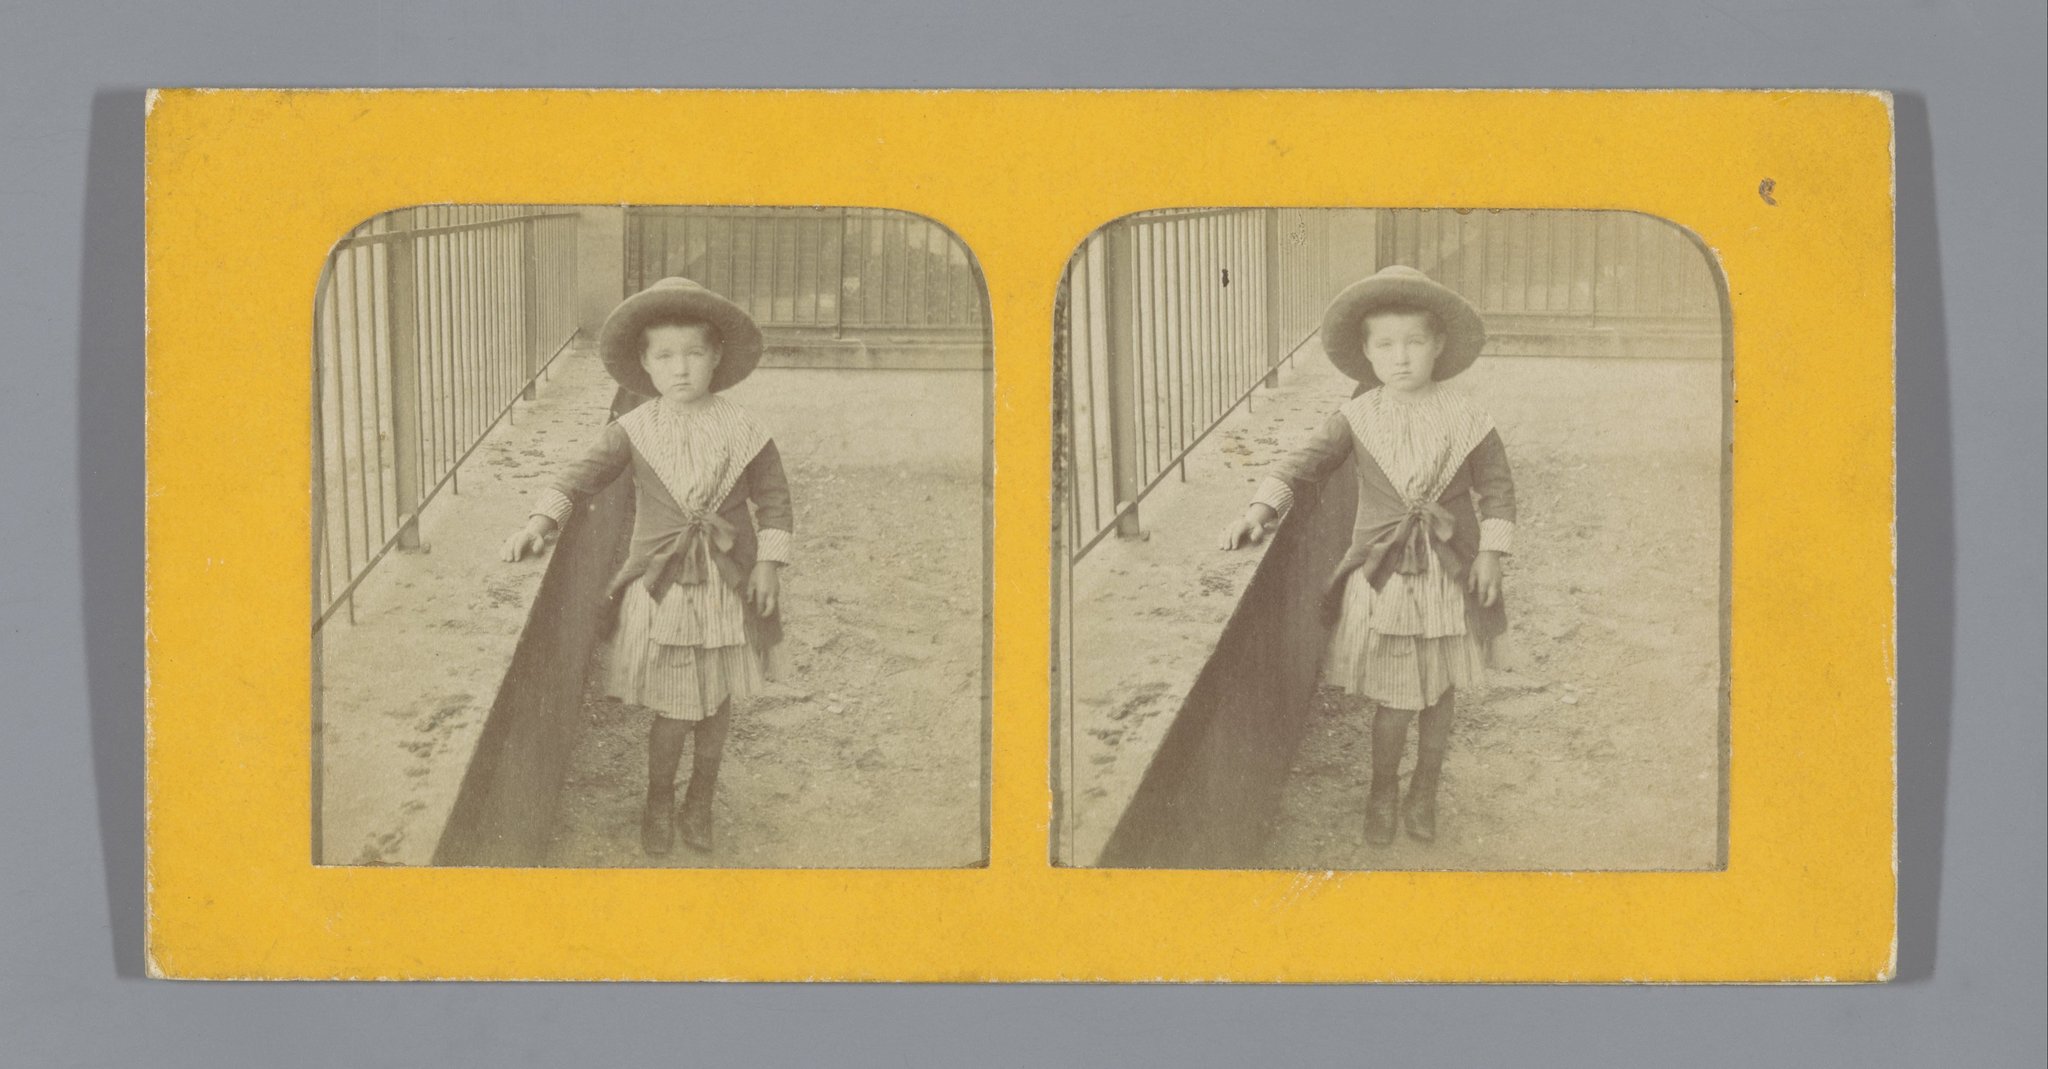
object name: tissue stereograph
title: Portret van een onbekend kind naast een hekwerk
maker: Anonymous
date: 1855-1875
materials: cardboard, paper, photographic support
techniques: albumen print, hand coloring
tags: toddler, anonymous historical person portrayed